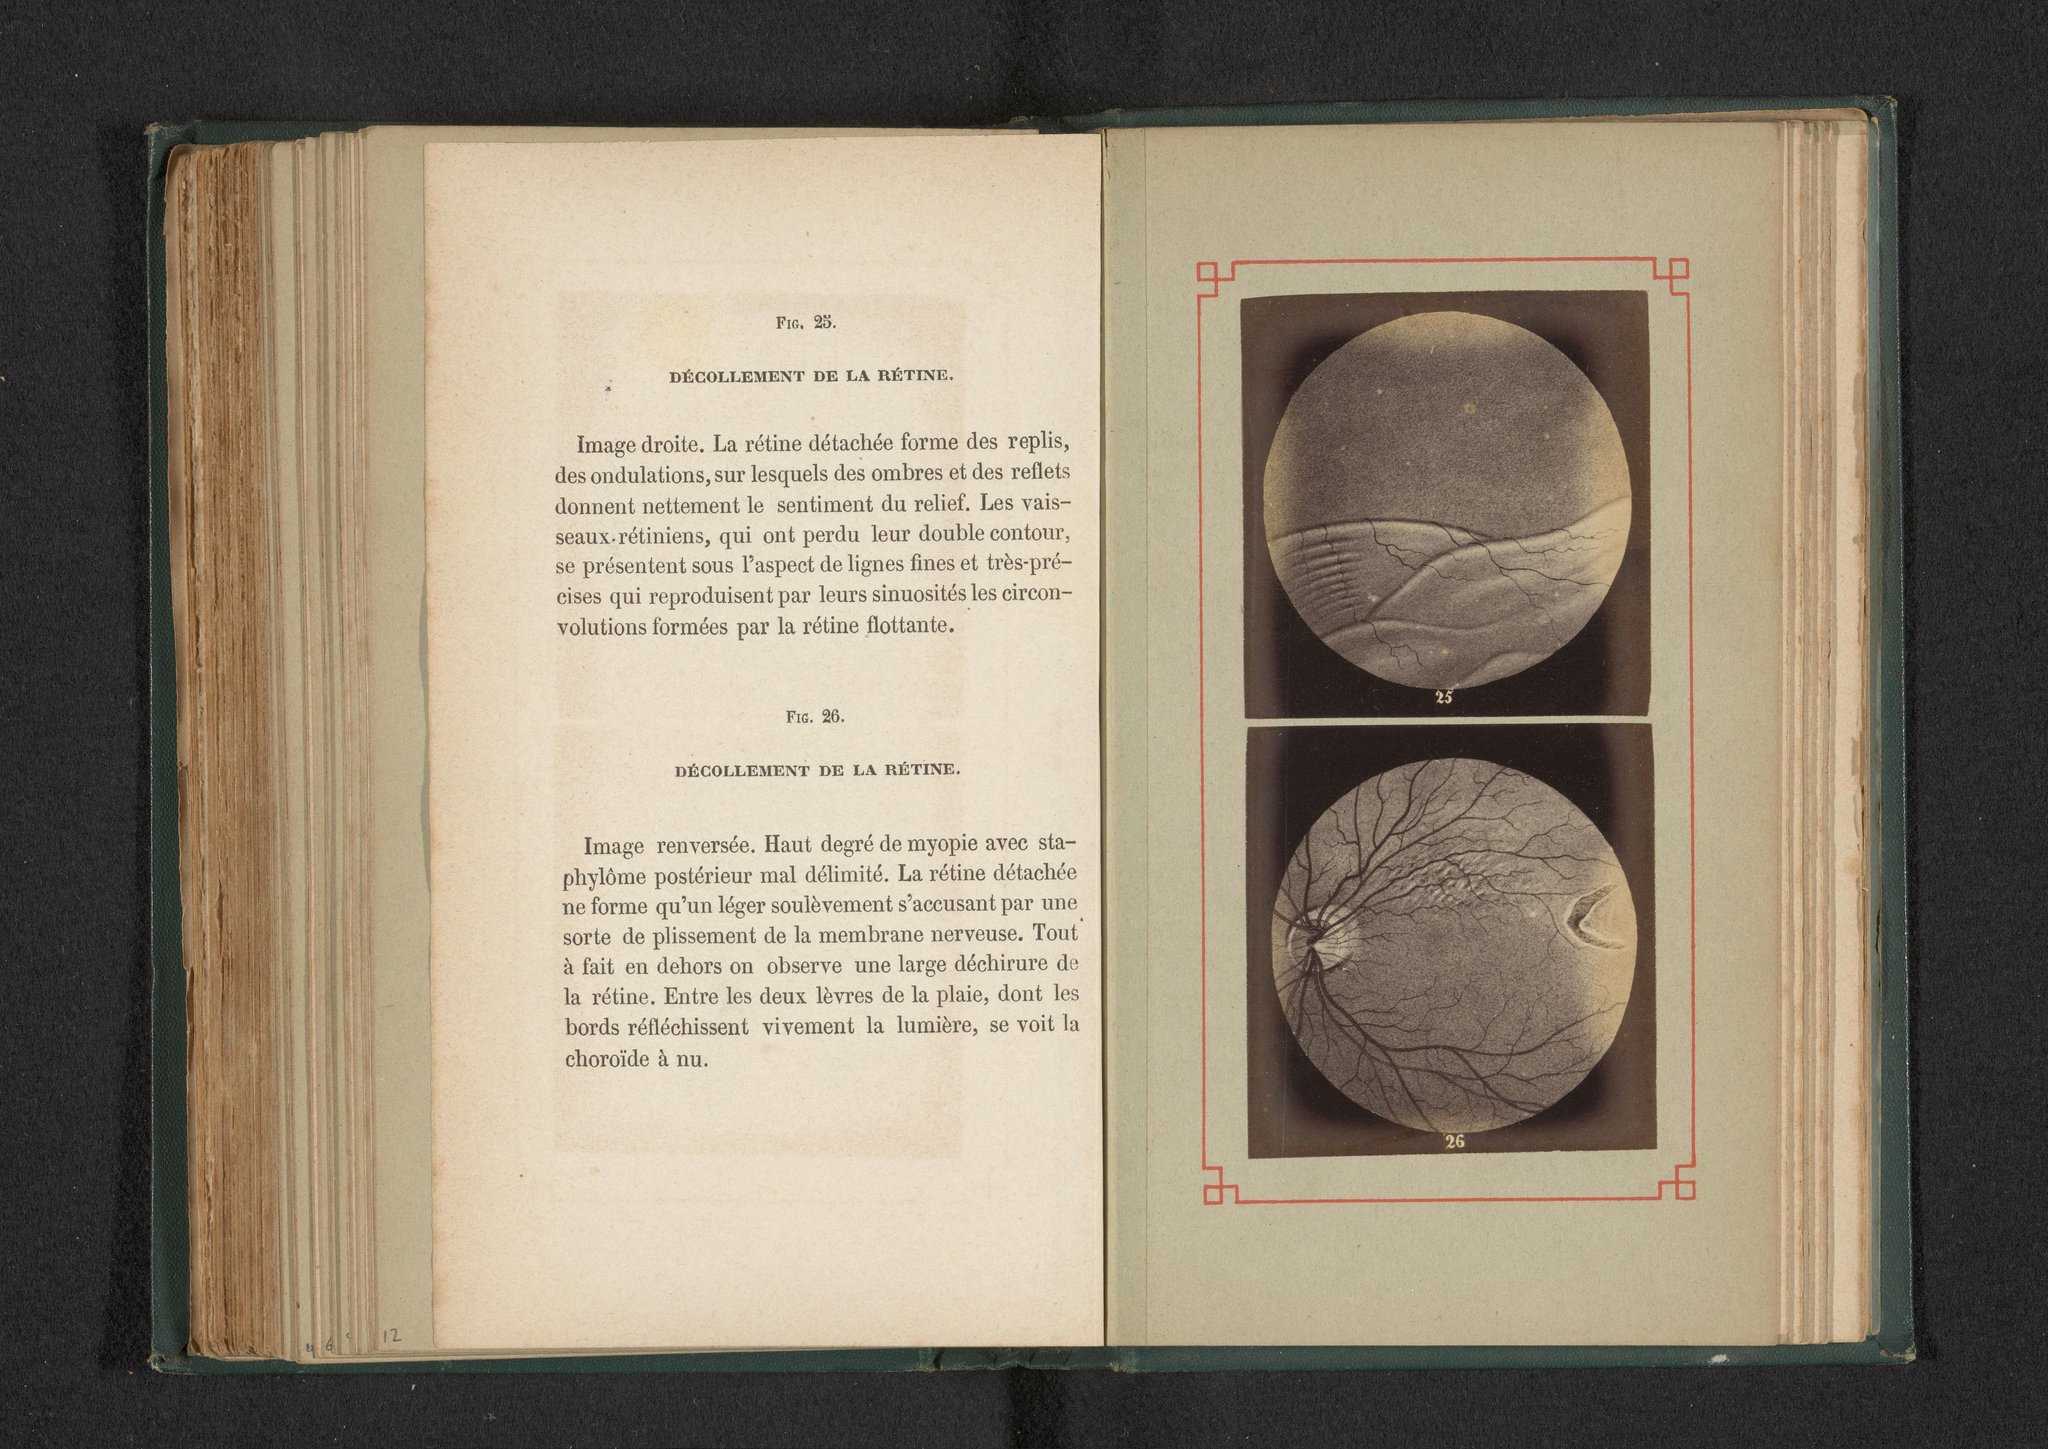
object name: page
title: Fotoreproductie van twee anatomische tekeningen van het loslaten van het netvlies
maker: Anonymous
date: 1871-1881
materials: photographic support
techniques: albumen print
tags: anatomy (non-medical), eyes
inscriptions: inscription: ‘Fig. 25. Décollement de la rétine. Fig. 26. Décollement de la rétine.’